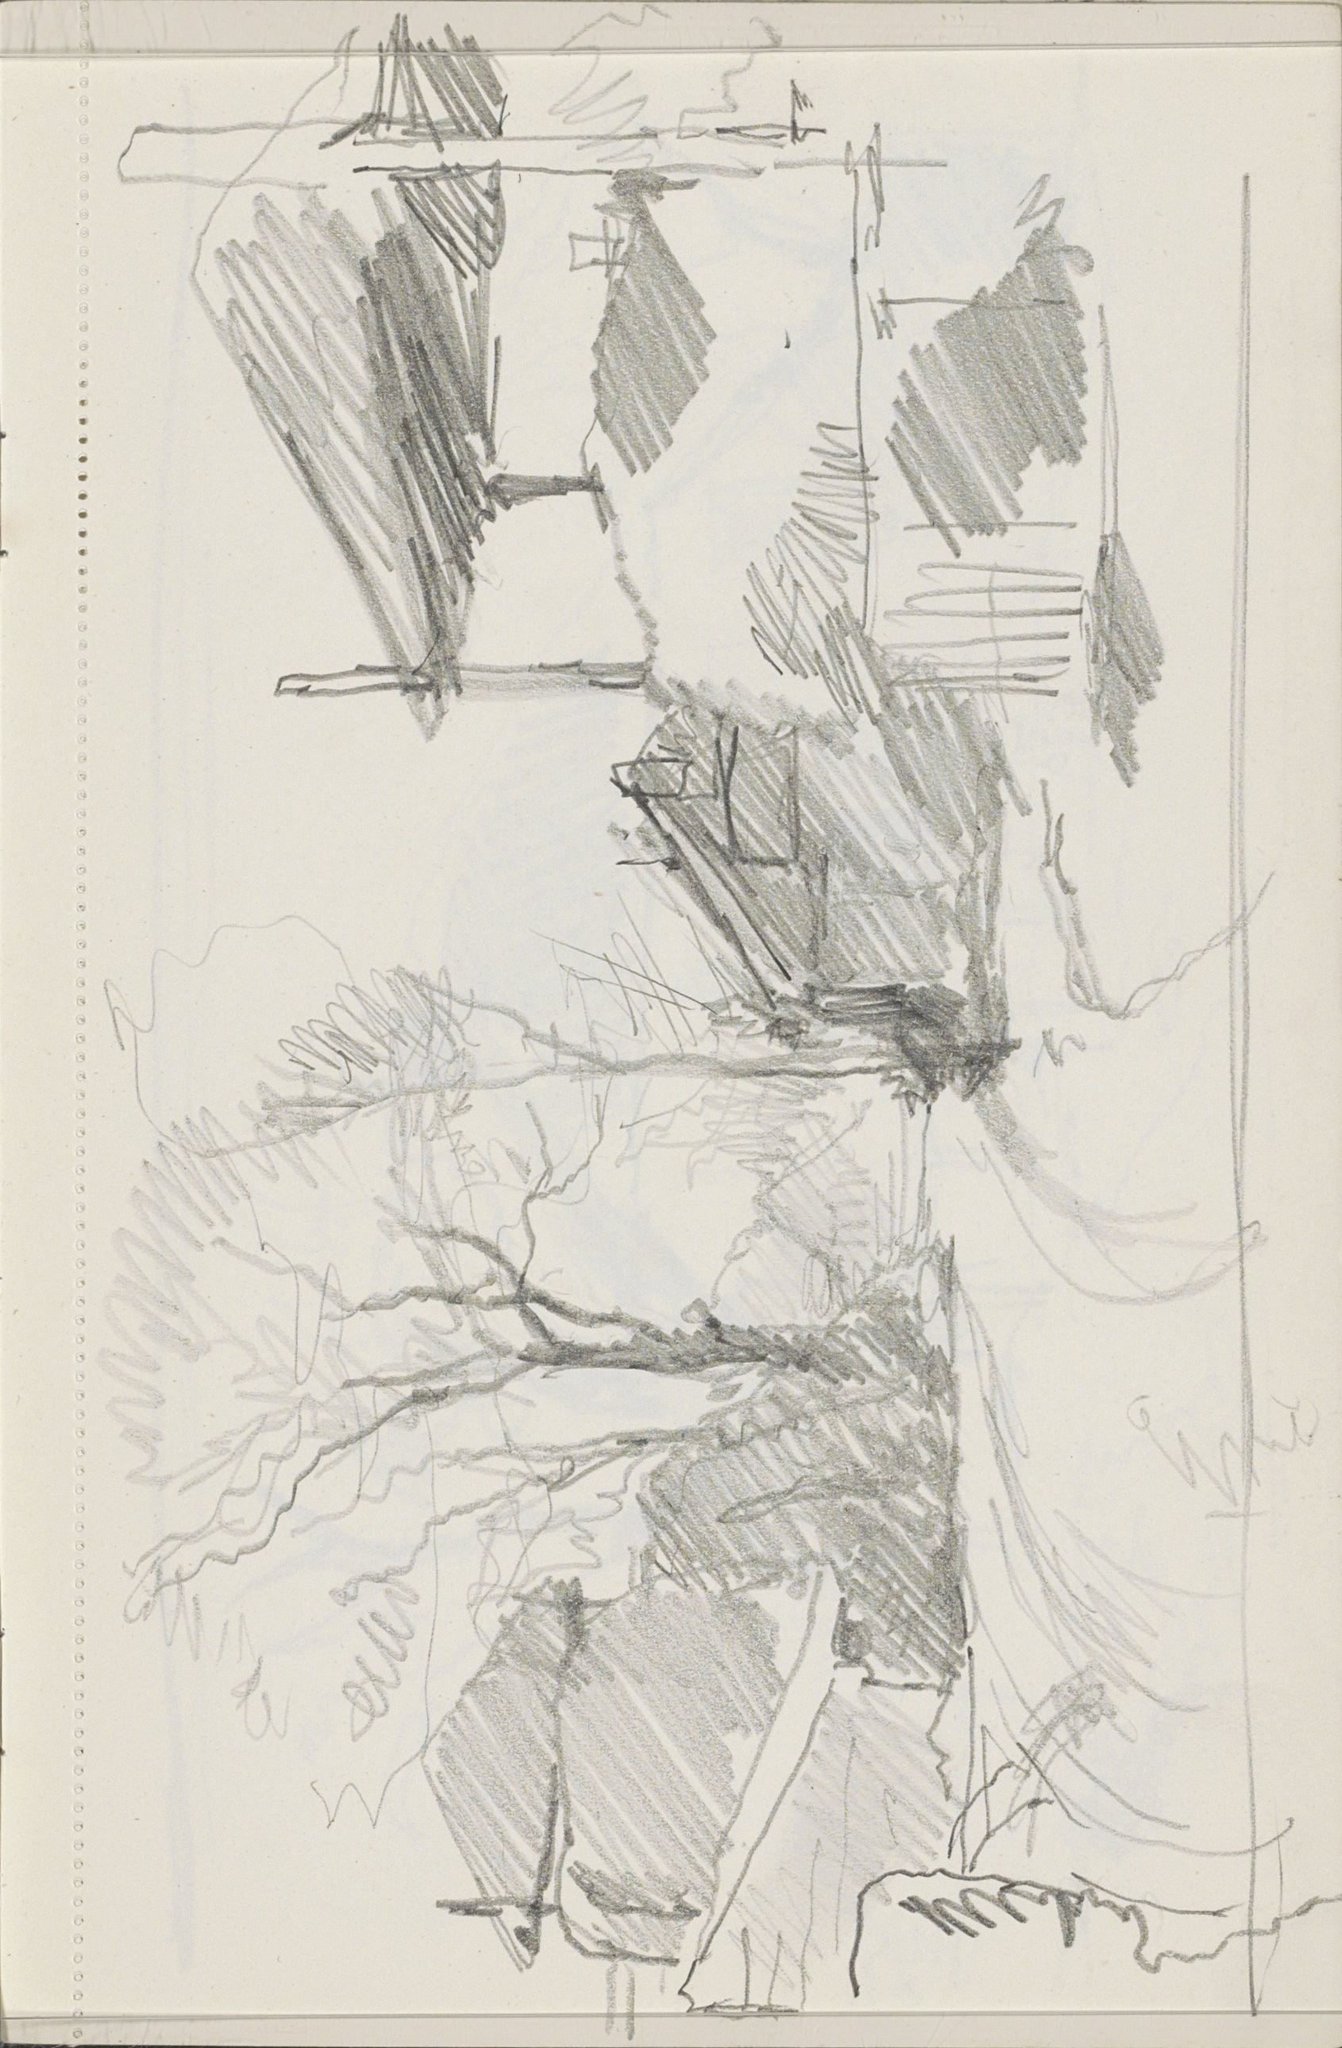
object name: sketchbook leaf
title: Huizen en een hooistapel aan een landweg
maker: cornelis vreedenburgh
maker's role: draughtsman, print maker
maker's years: 1880-1946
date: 1935-1936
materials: paper, pencil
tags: road, path, hay-stack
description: Blad 11 recto uit een schetsboek met 73 bladen.